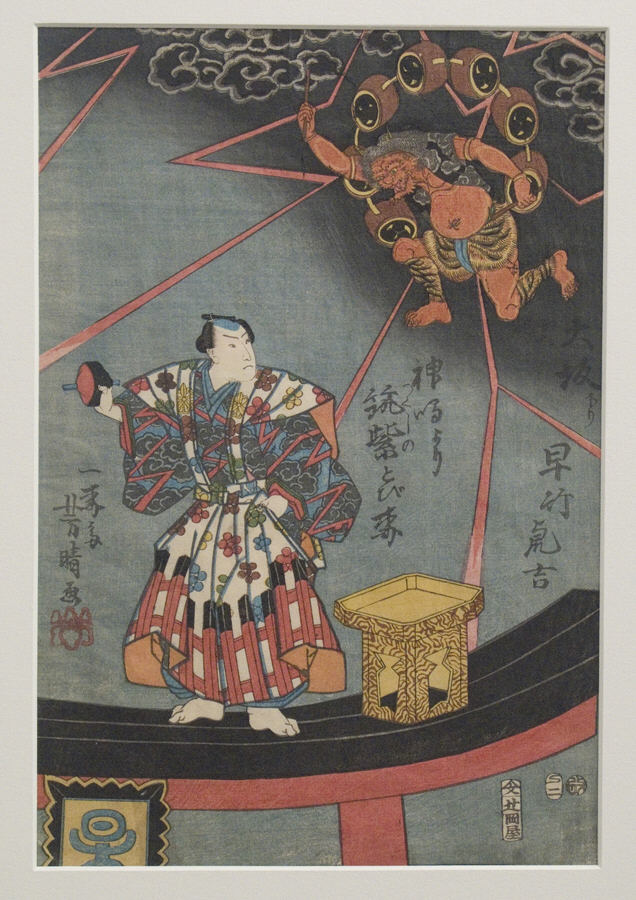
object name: print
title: The Plum Blossom that Flew on Lightning from Chikushino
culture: japanese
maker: utagawa yoshiharu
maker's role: artist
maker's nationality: japanese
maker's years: 1828-1888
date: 1857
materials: ink, paper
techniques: woodblock print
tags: men,lightning